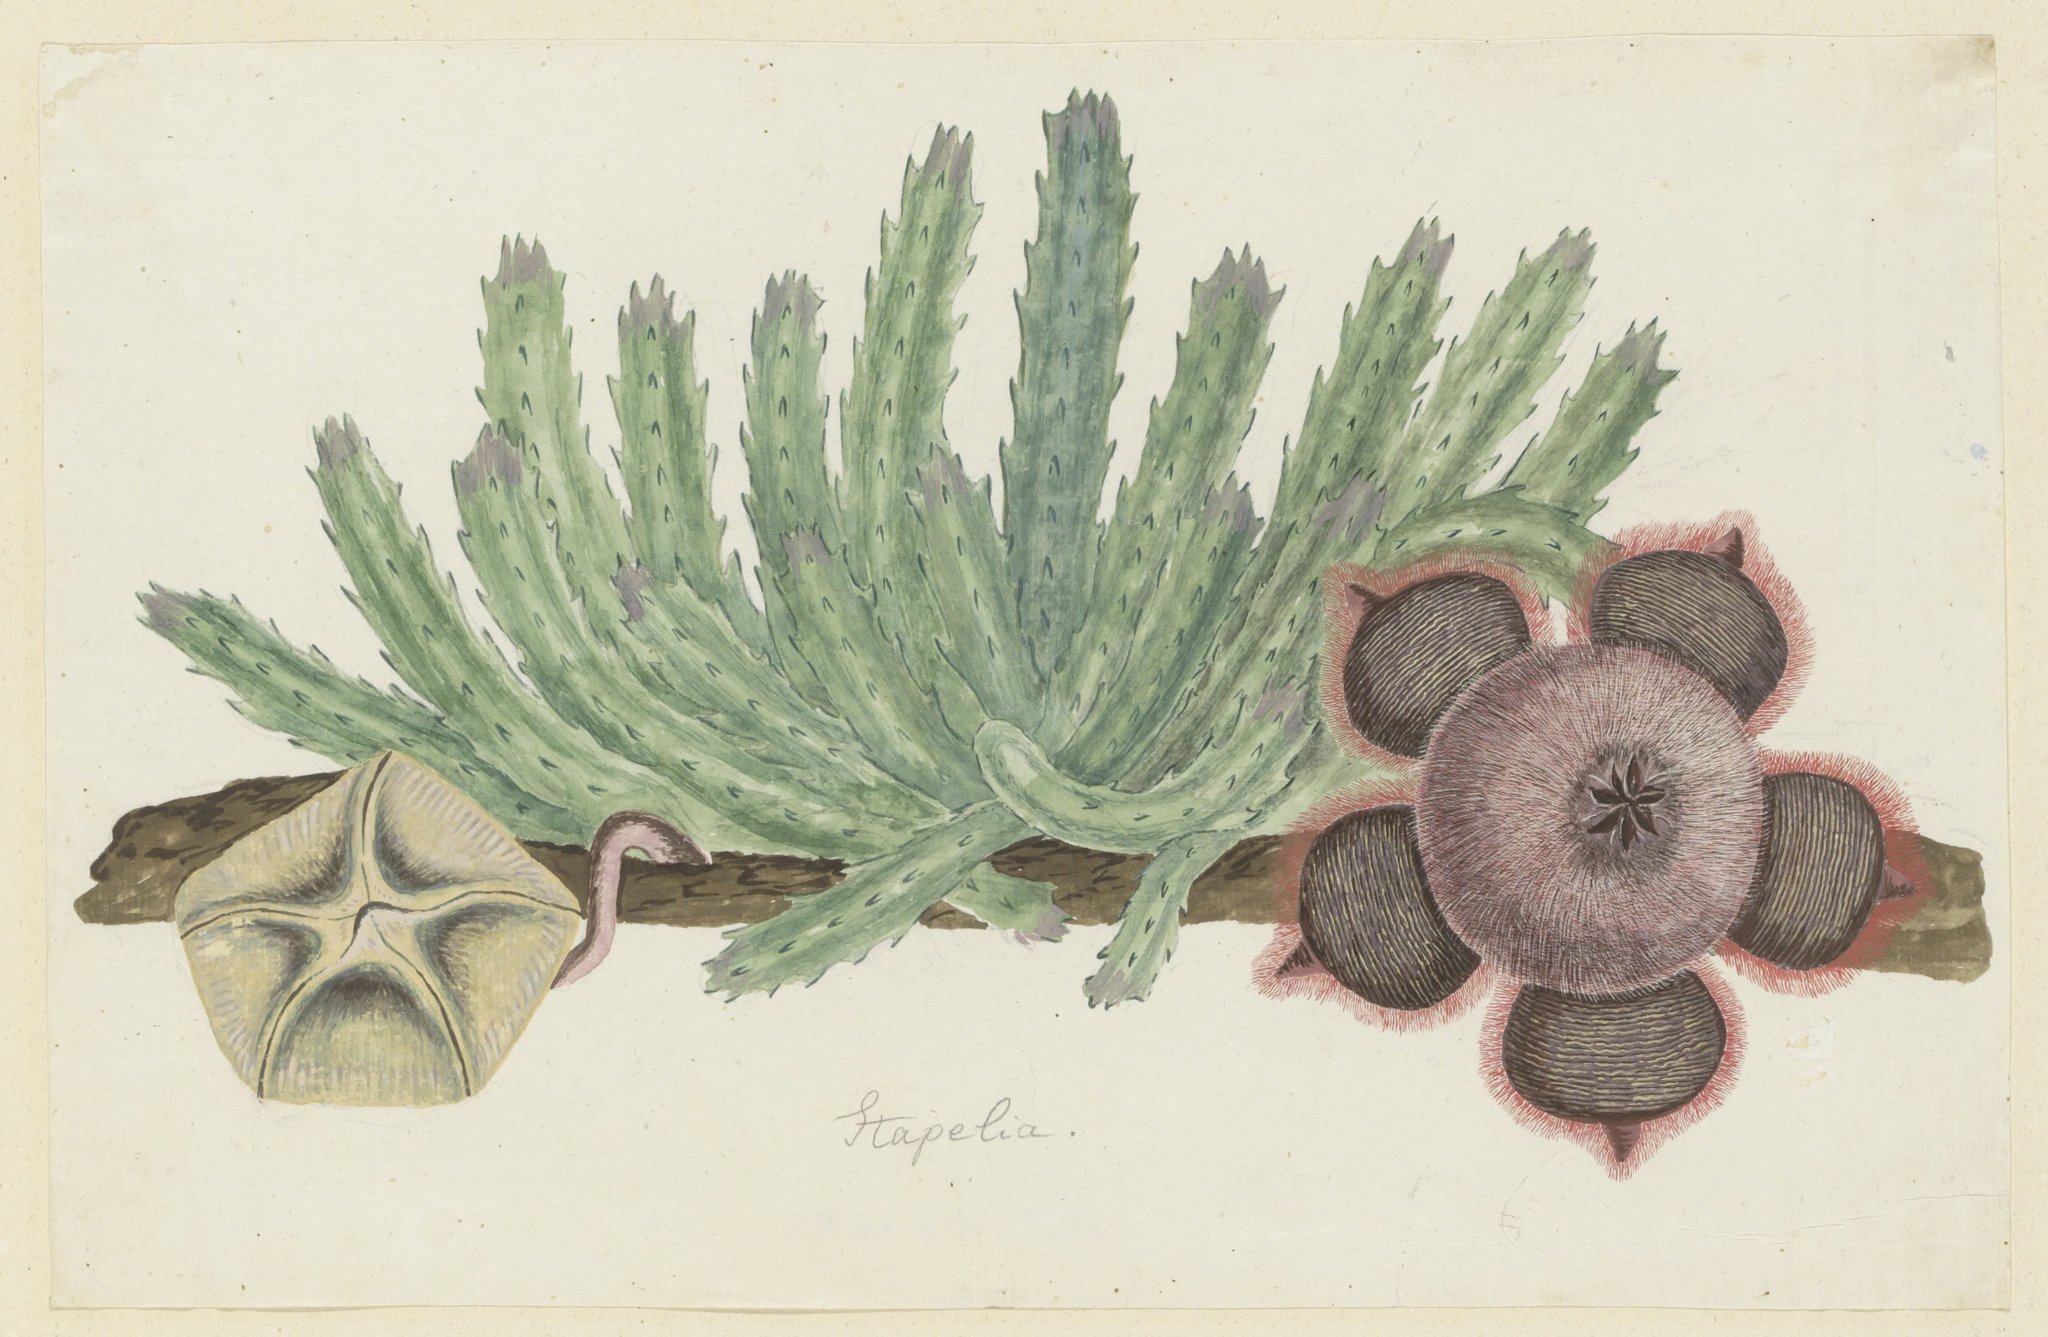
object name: drawing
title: Stapelia hirsuta (L.) (Starfish flower)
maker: robert jacob gordon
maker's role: draughtsman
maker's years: 1743-1795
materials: chalk, paint, ink, paper, pencil, watercolor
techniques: brush, pen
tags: plants; vegetation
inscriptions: annotation: ‘Stapelia.’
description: De tekening is gemaakt voor of tijdens een van Gordon's vier expedities door de Kaapprovincie, van oktober 1777 tot maart 1786. Sommige (soort)namen kunnen zijn gewijzigd, gezien reorganisatie in plantentaxonomie gedurende de afgelopen jaren.